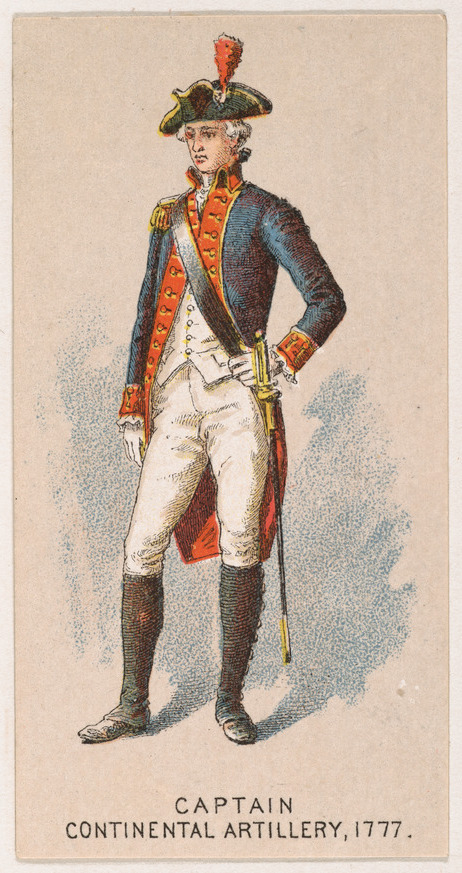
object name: print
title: Captain, Continental Artillery, 1777, from the Military Series (N224) issued by Kinney Tobacco Company to promote Sweet Caporal Cigarettes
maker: kinney brothers tobacco company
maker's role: publisher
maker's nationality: american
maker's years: 1869-2011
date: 1888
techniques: color lithograph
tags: military,men